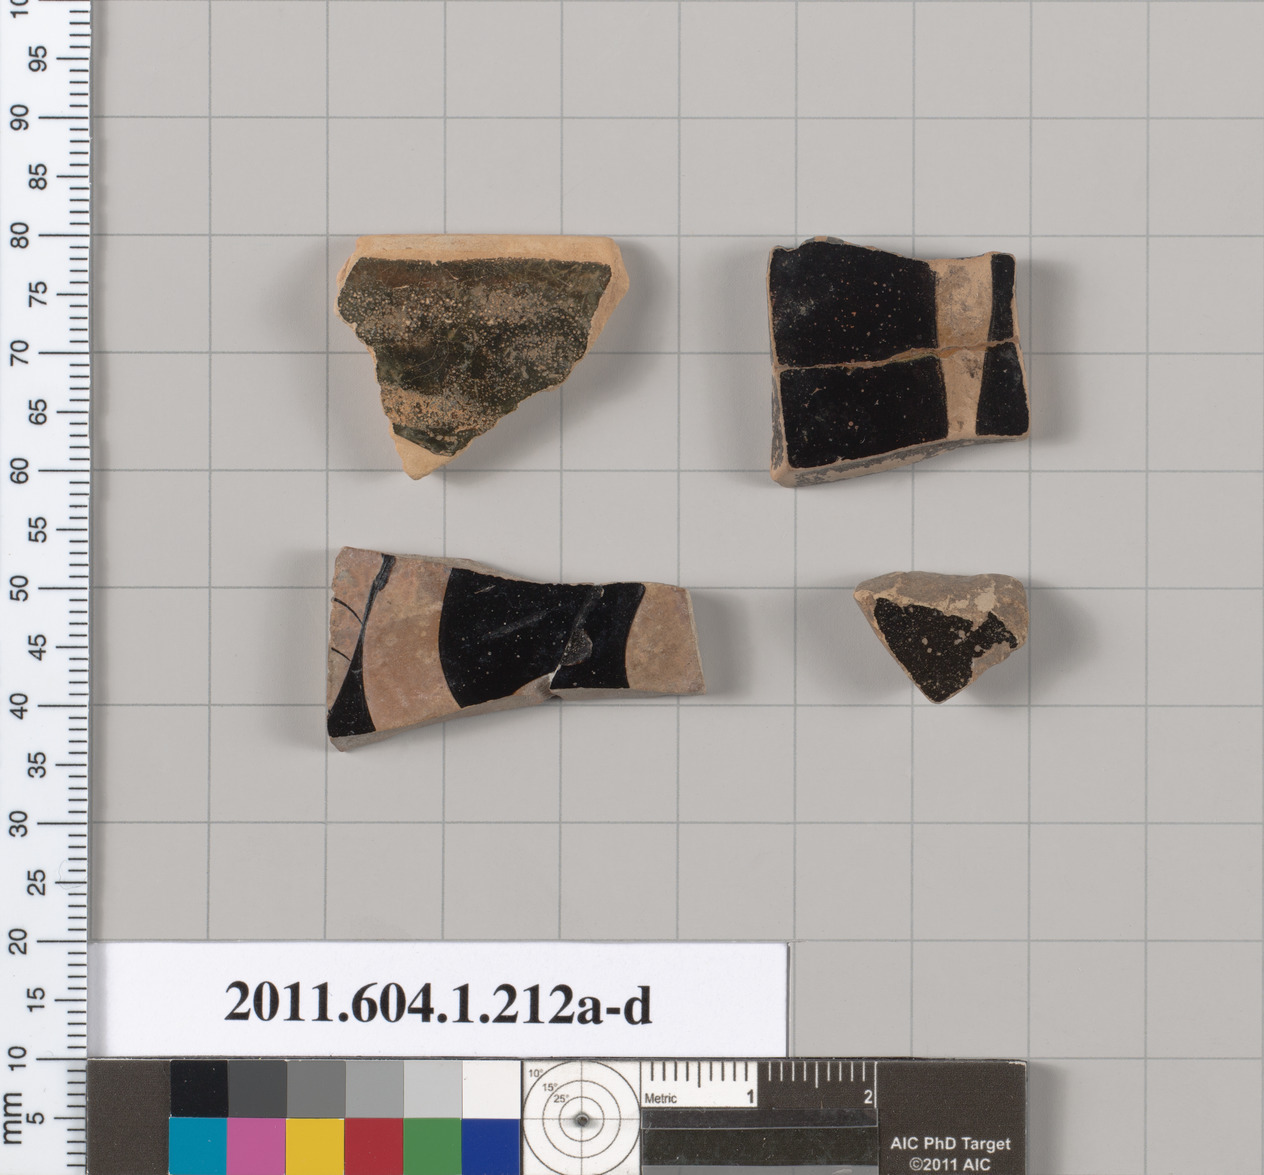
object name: kylix fragment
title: Terracotta fragments of a kylix (drinking cup)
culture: greek, attic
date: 475-451 BCE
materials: terracotta